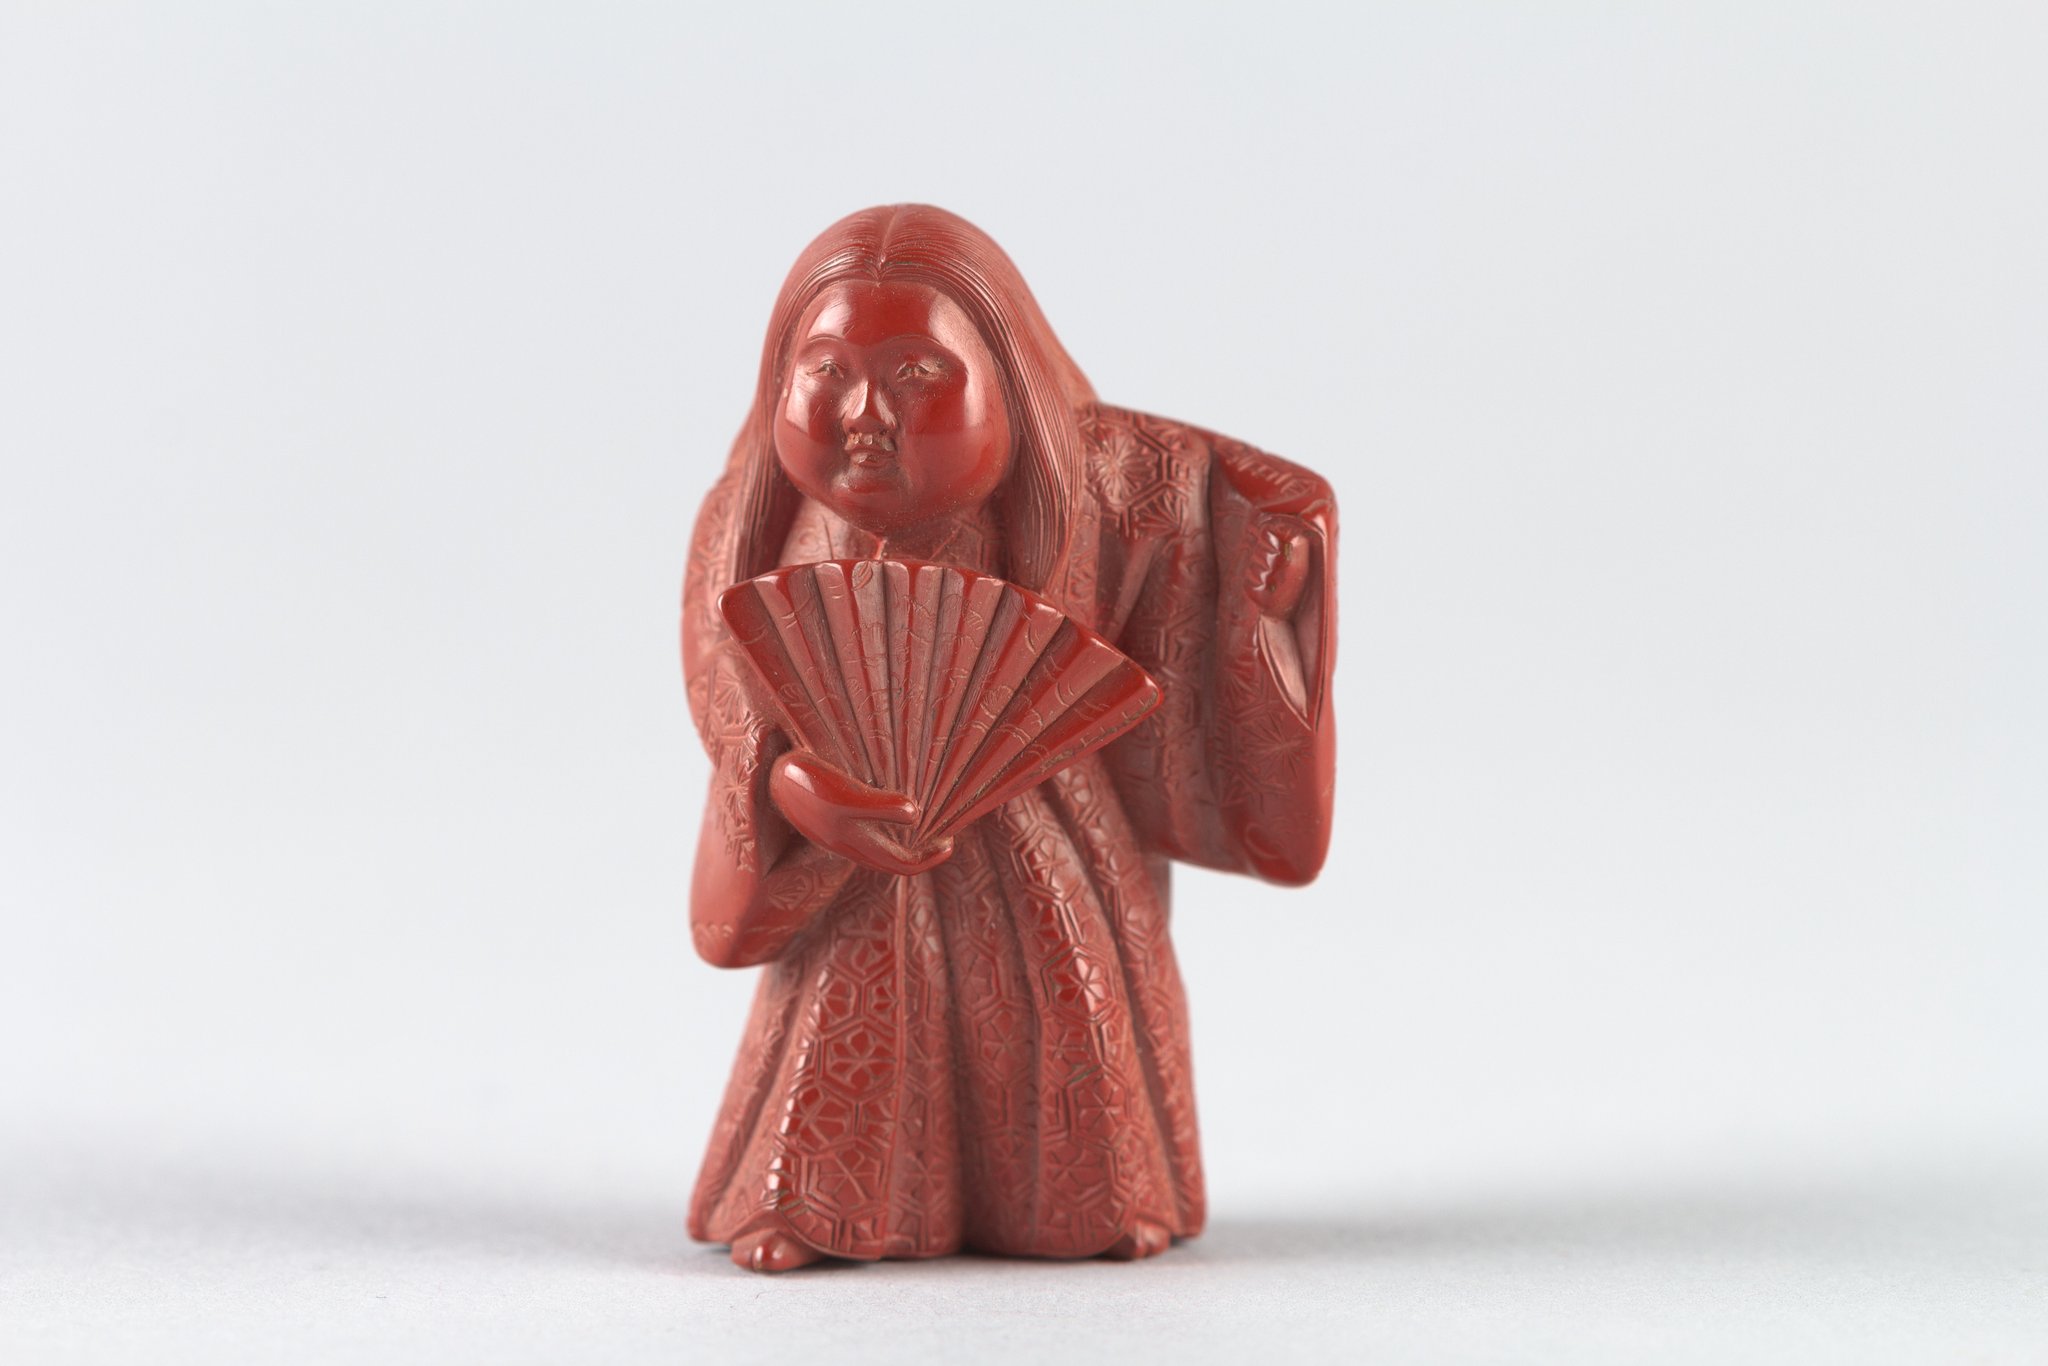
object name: netsuke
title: Netsuke of Noh Dancer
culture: japanese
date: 1801-1900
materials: lacquer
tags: fans,women,dancers